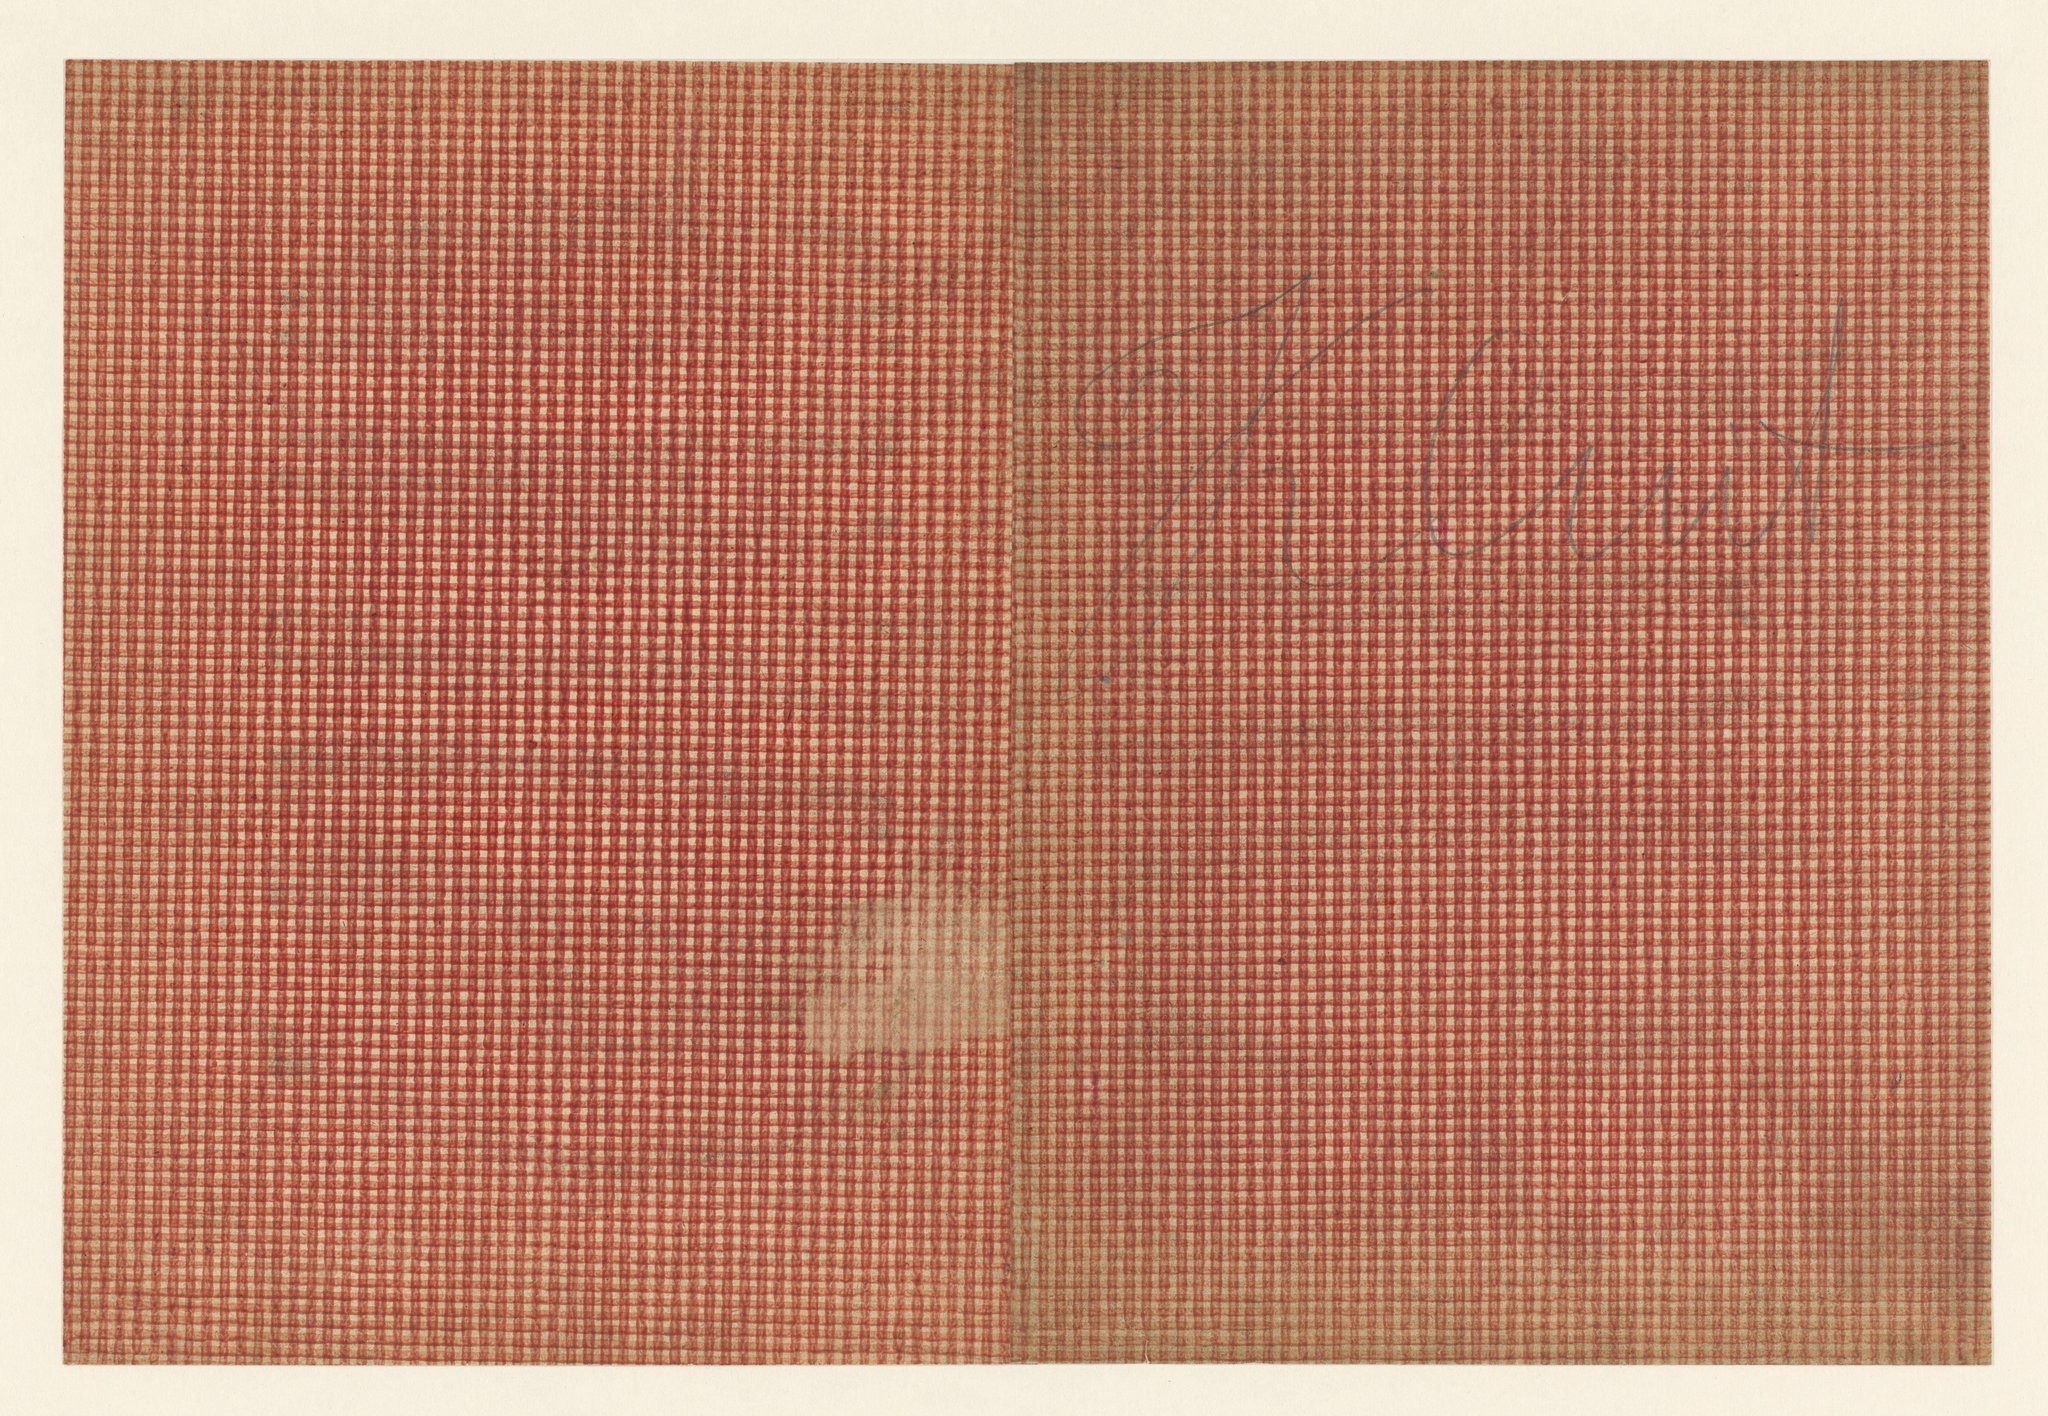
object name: wrapper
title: Blad met schaakbordpatroon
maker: Anonymous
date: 1700-1850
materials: paper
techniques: printing block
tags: ornament ~ geometric motifs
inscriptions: annotation: ‘JWit’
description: Blad met schaakbordpatroon. Gebruikt als omslag.